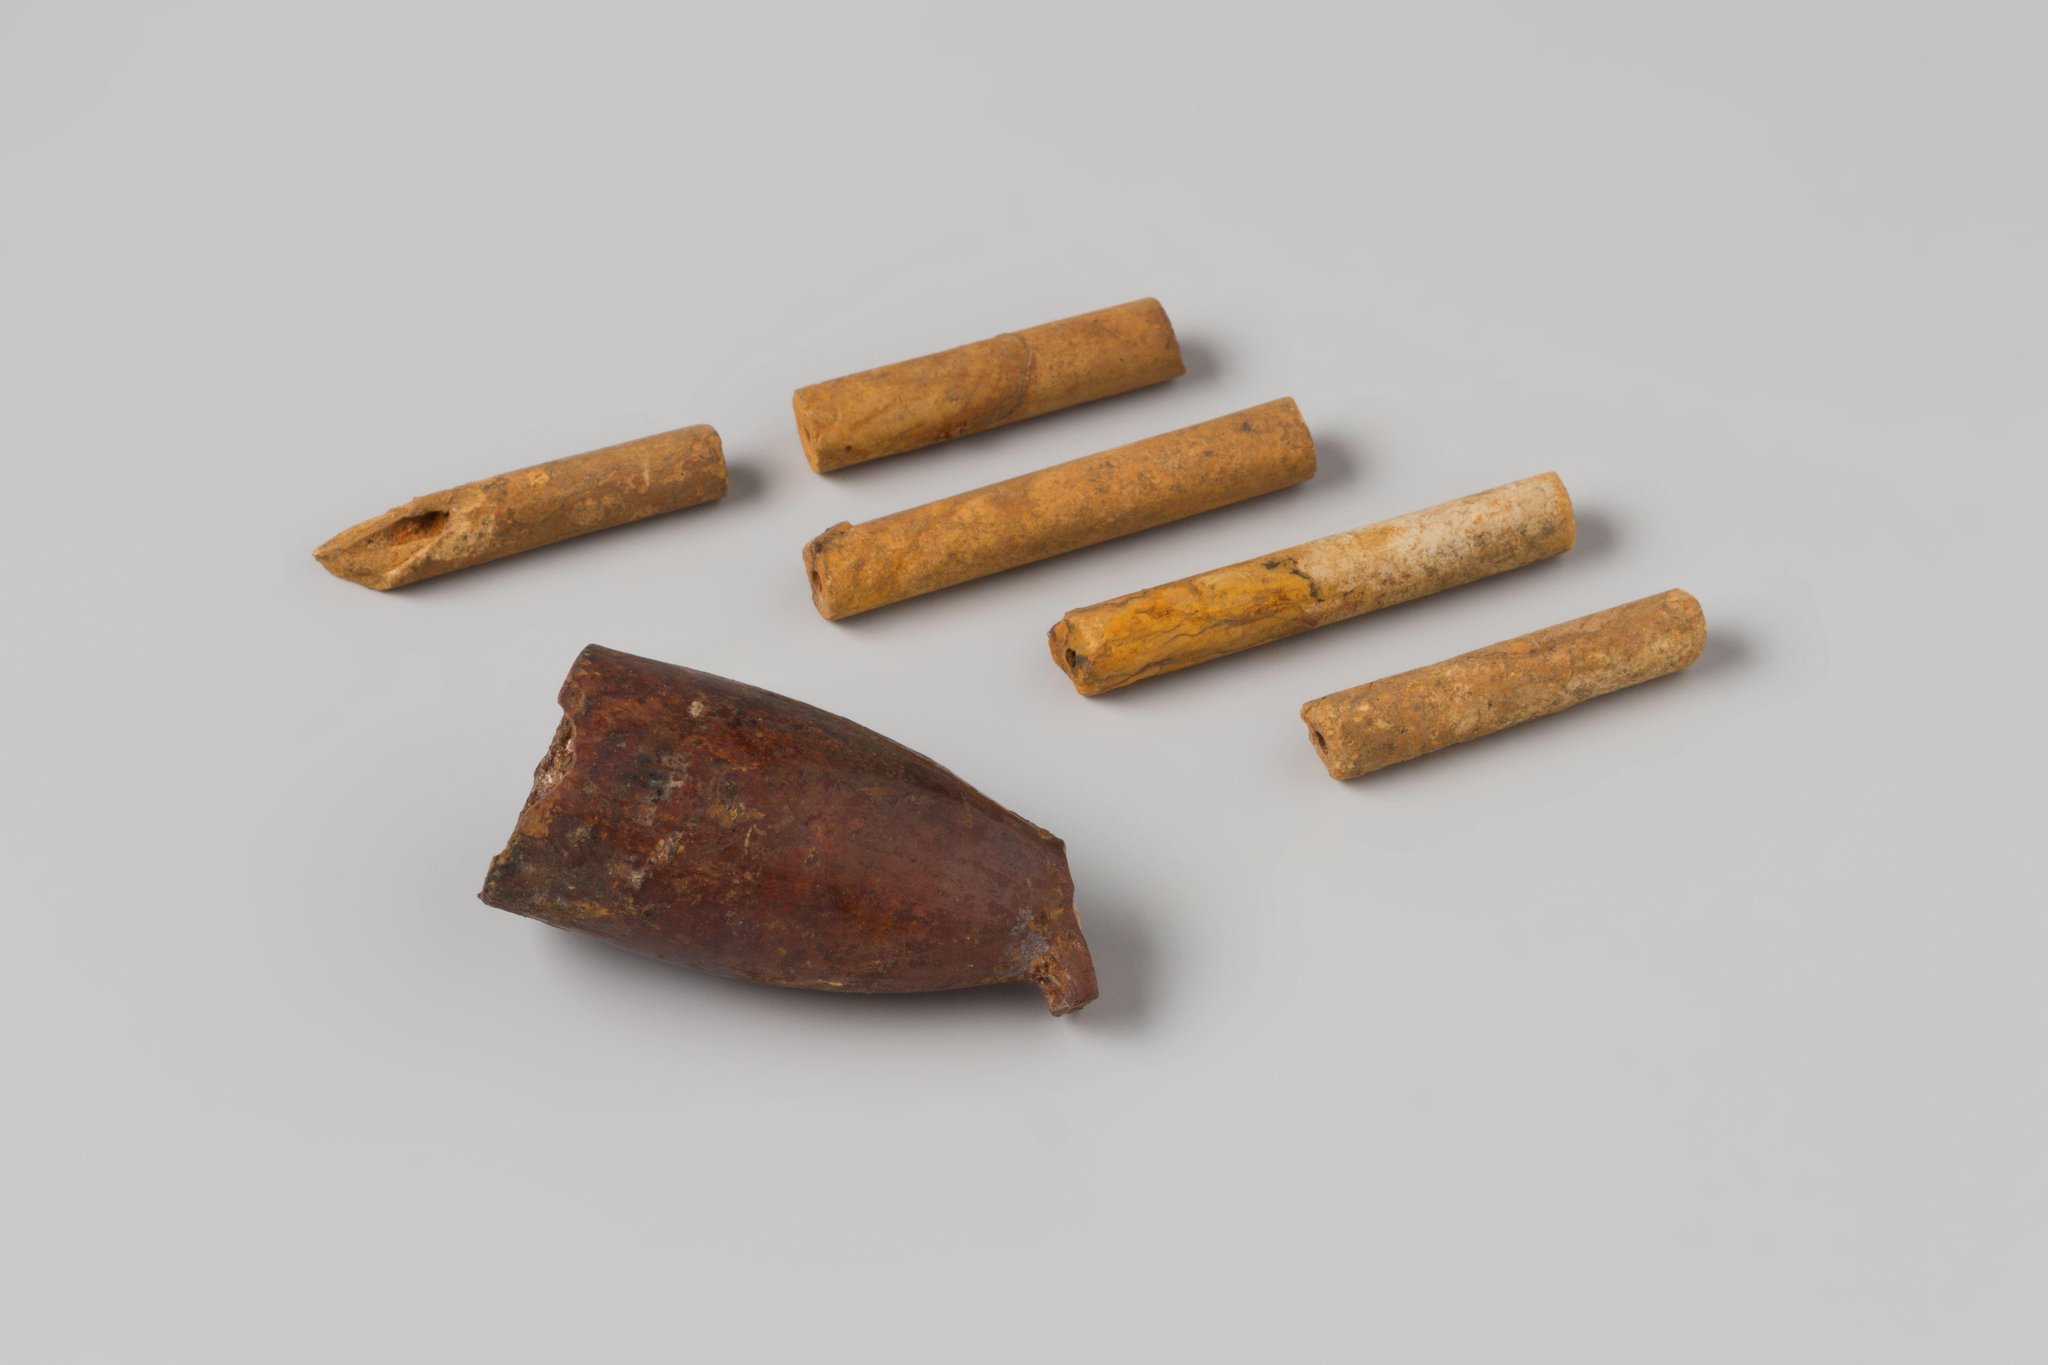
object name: pipe bowl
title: Pijpenkop en fragmenten pijpenstelen uit het wrak van de Oost-Indiëvaarder Hollandia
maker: Anonymous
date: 1700-1743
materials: clay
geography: netherlands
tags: verenigde oostindische compagnie, hollandia (schip), annet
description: Pipe, bowl, heelmark: coat of arms of the city of Amsterdam; fragm, 1hsm2.